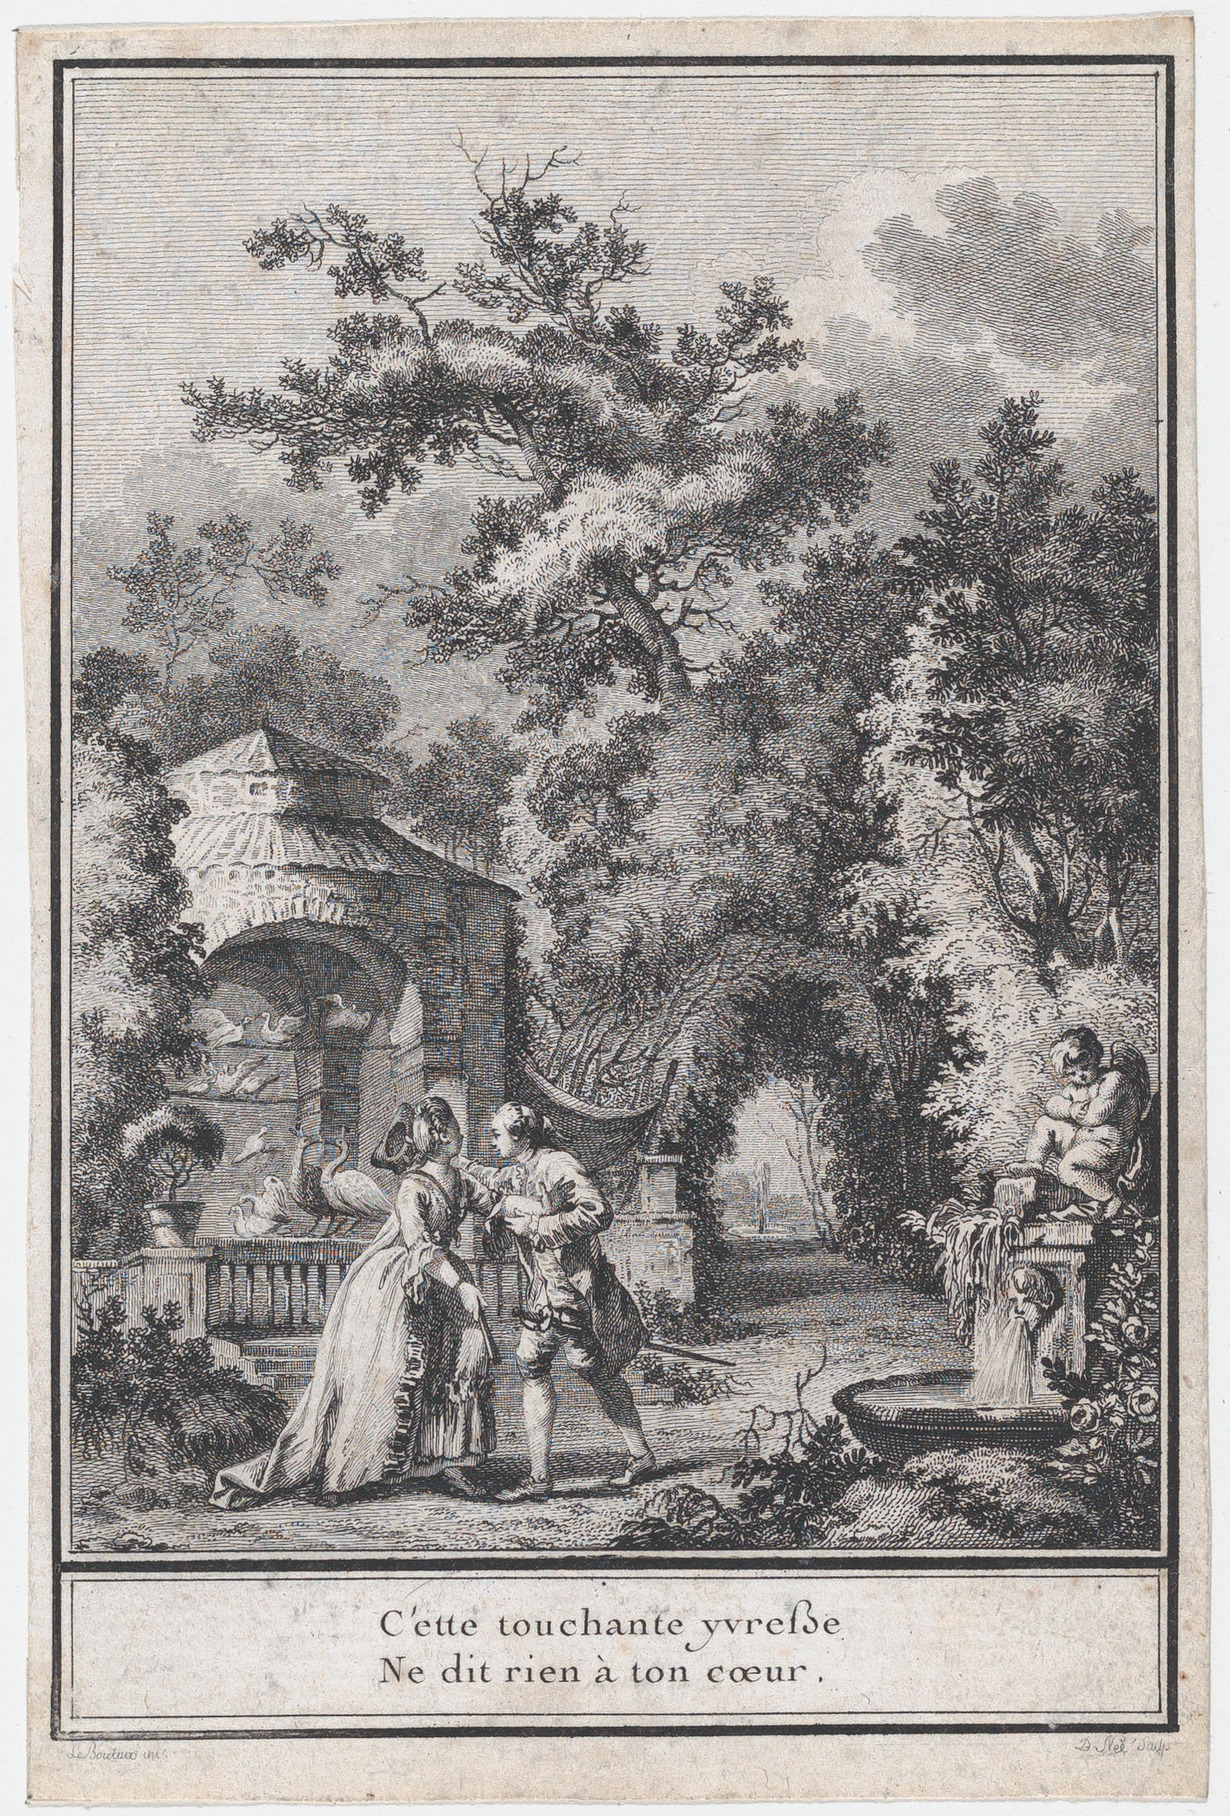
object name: print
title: Choice of Songs put into Music by M. de la Borde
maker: françois denis née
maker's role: artist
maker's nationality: french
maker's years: 1732-1817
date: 1773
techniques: engraving, etching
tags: birds,fountains,men,women